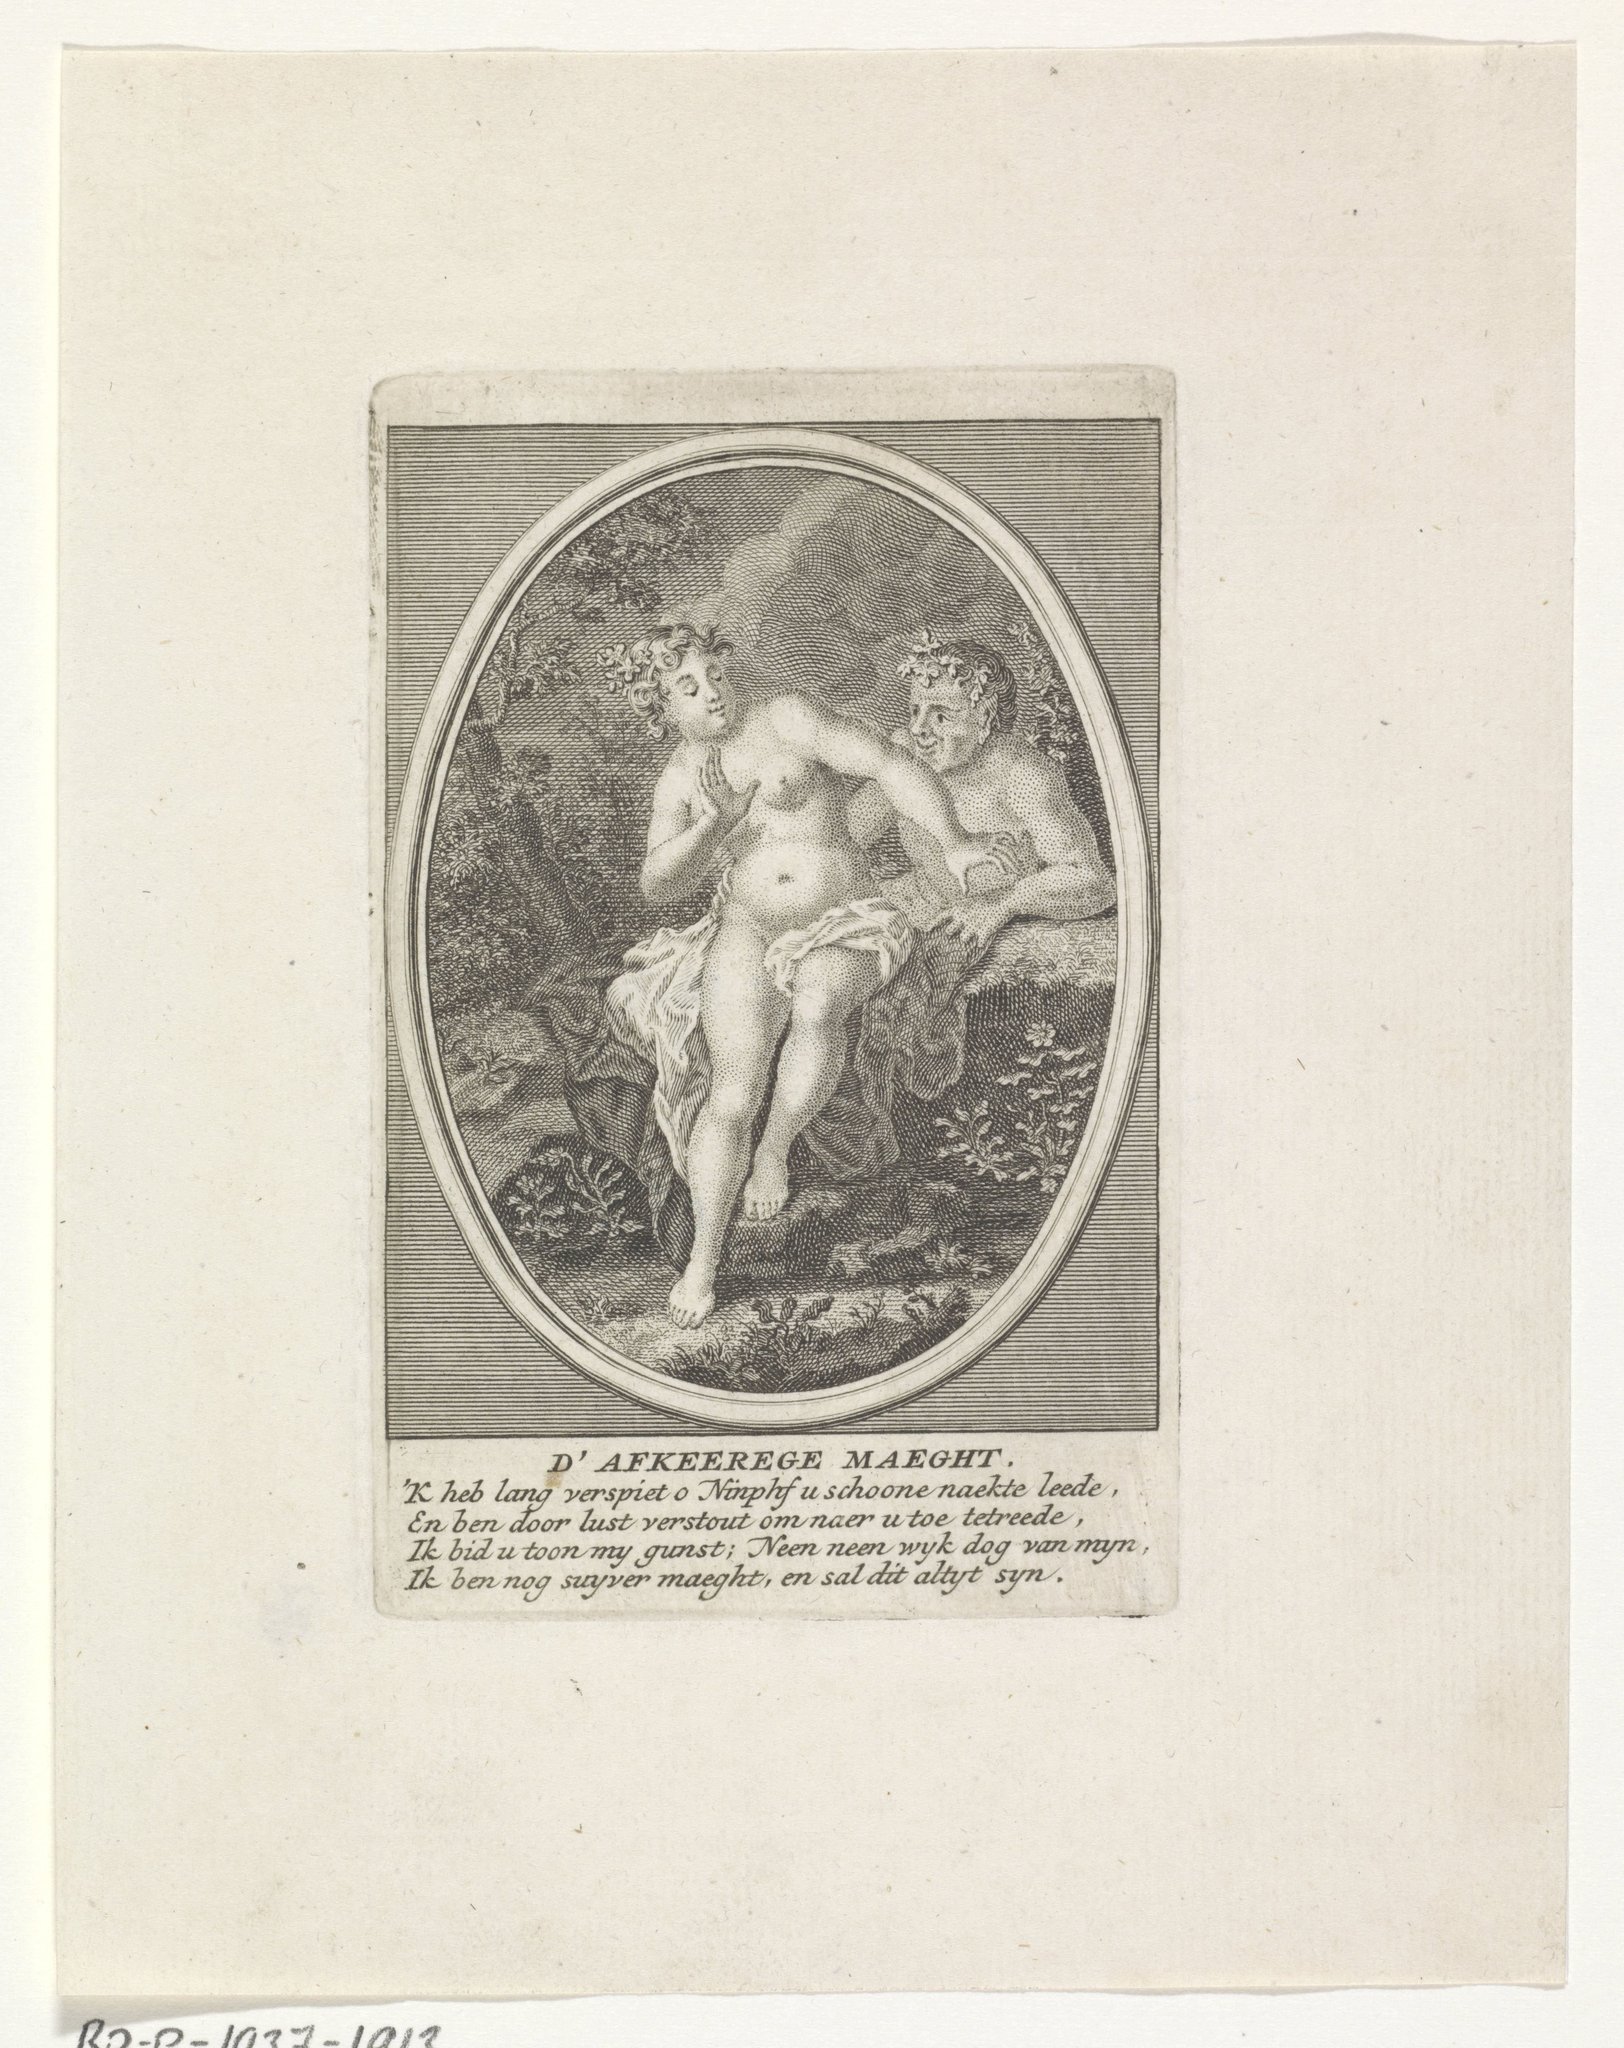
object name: print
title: Vrouw wijst een man af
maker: Anonymous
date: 1700-1900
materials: paper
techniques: engraving, etching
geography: netherlands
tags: being refused, the proposal rejected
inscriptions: collector's mark: Lugt 2228, collector's mark: Lugt 2760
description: Een naakte vrouw wijst een man af in een landschap. Onder de voorstelling een vierregelig vers in het Nederlands.